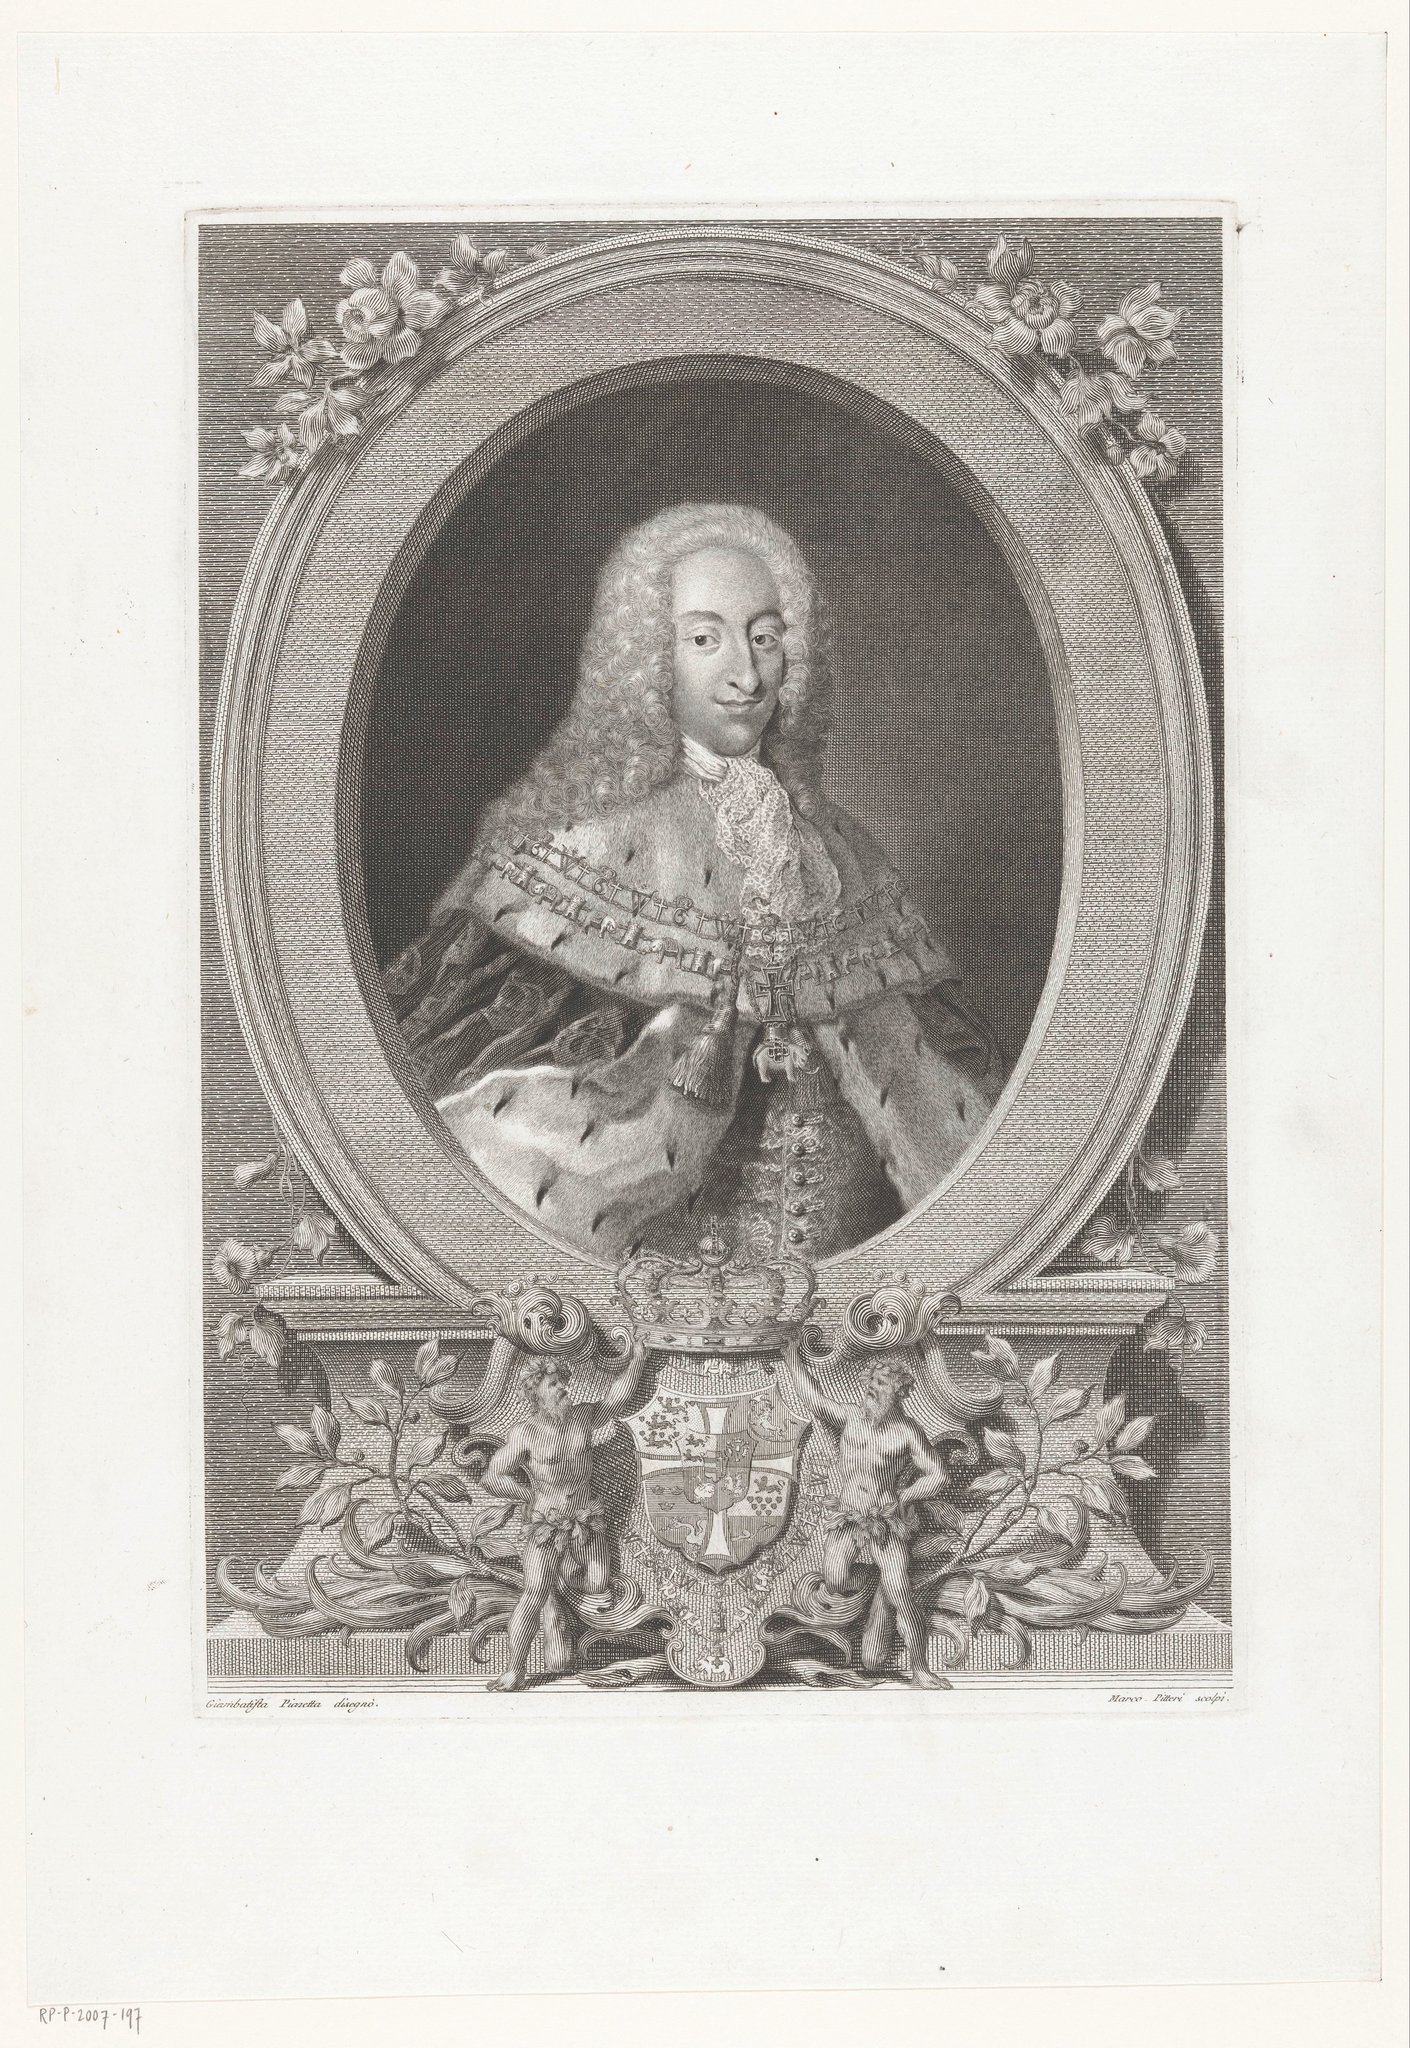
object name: print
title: Portret van Christiaan VI, koning van Denemarken en Noorwegen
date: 1730-1746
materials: paper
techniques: engraving, etching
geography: venice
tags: copenhagen (city), historical persons, ruler, sovereign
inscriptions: collector's mark: Lugt 2760, collector's mark: Lugt 2228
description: Portret van Christiaan VI, koning van Denemarken en Noorwegen met allongepruik, in hermelijnen mantel. Om zijn schouders een keten van de Orde van de Olifant. In ovaal. Onder het portret het familiewapen met koningskroon, gedragen door twee wildemannen.